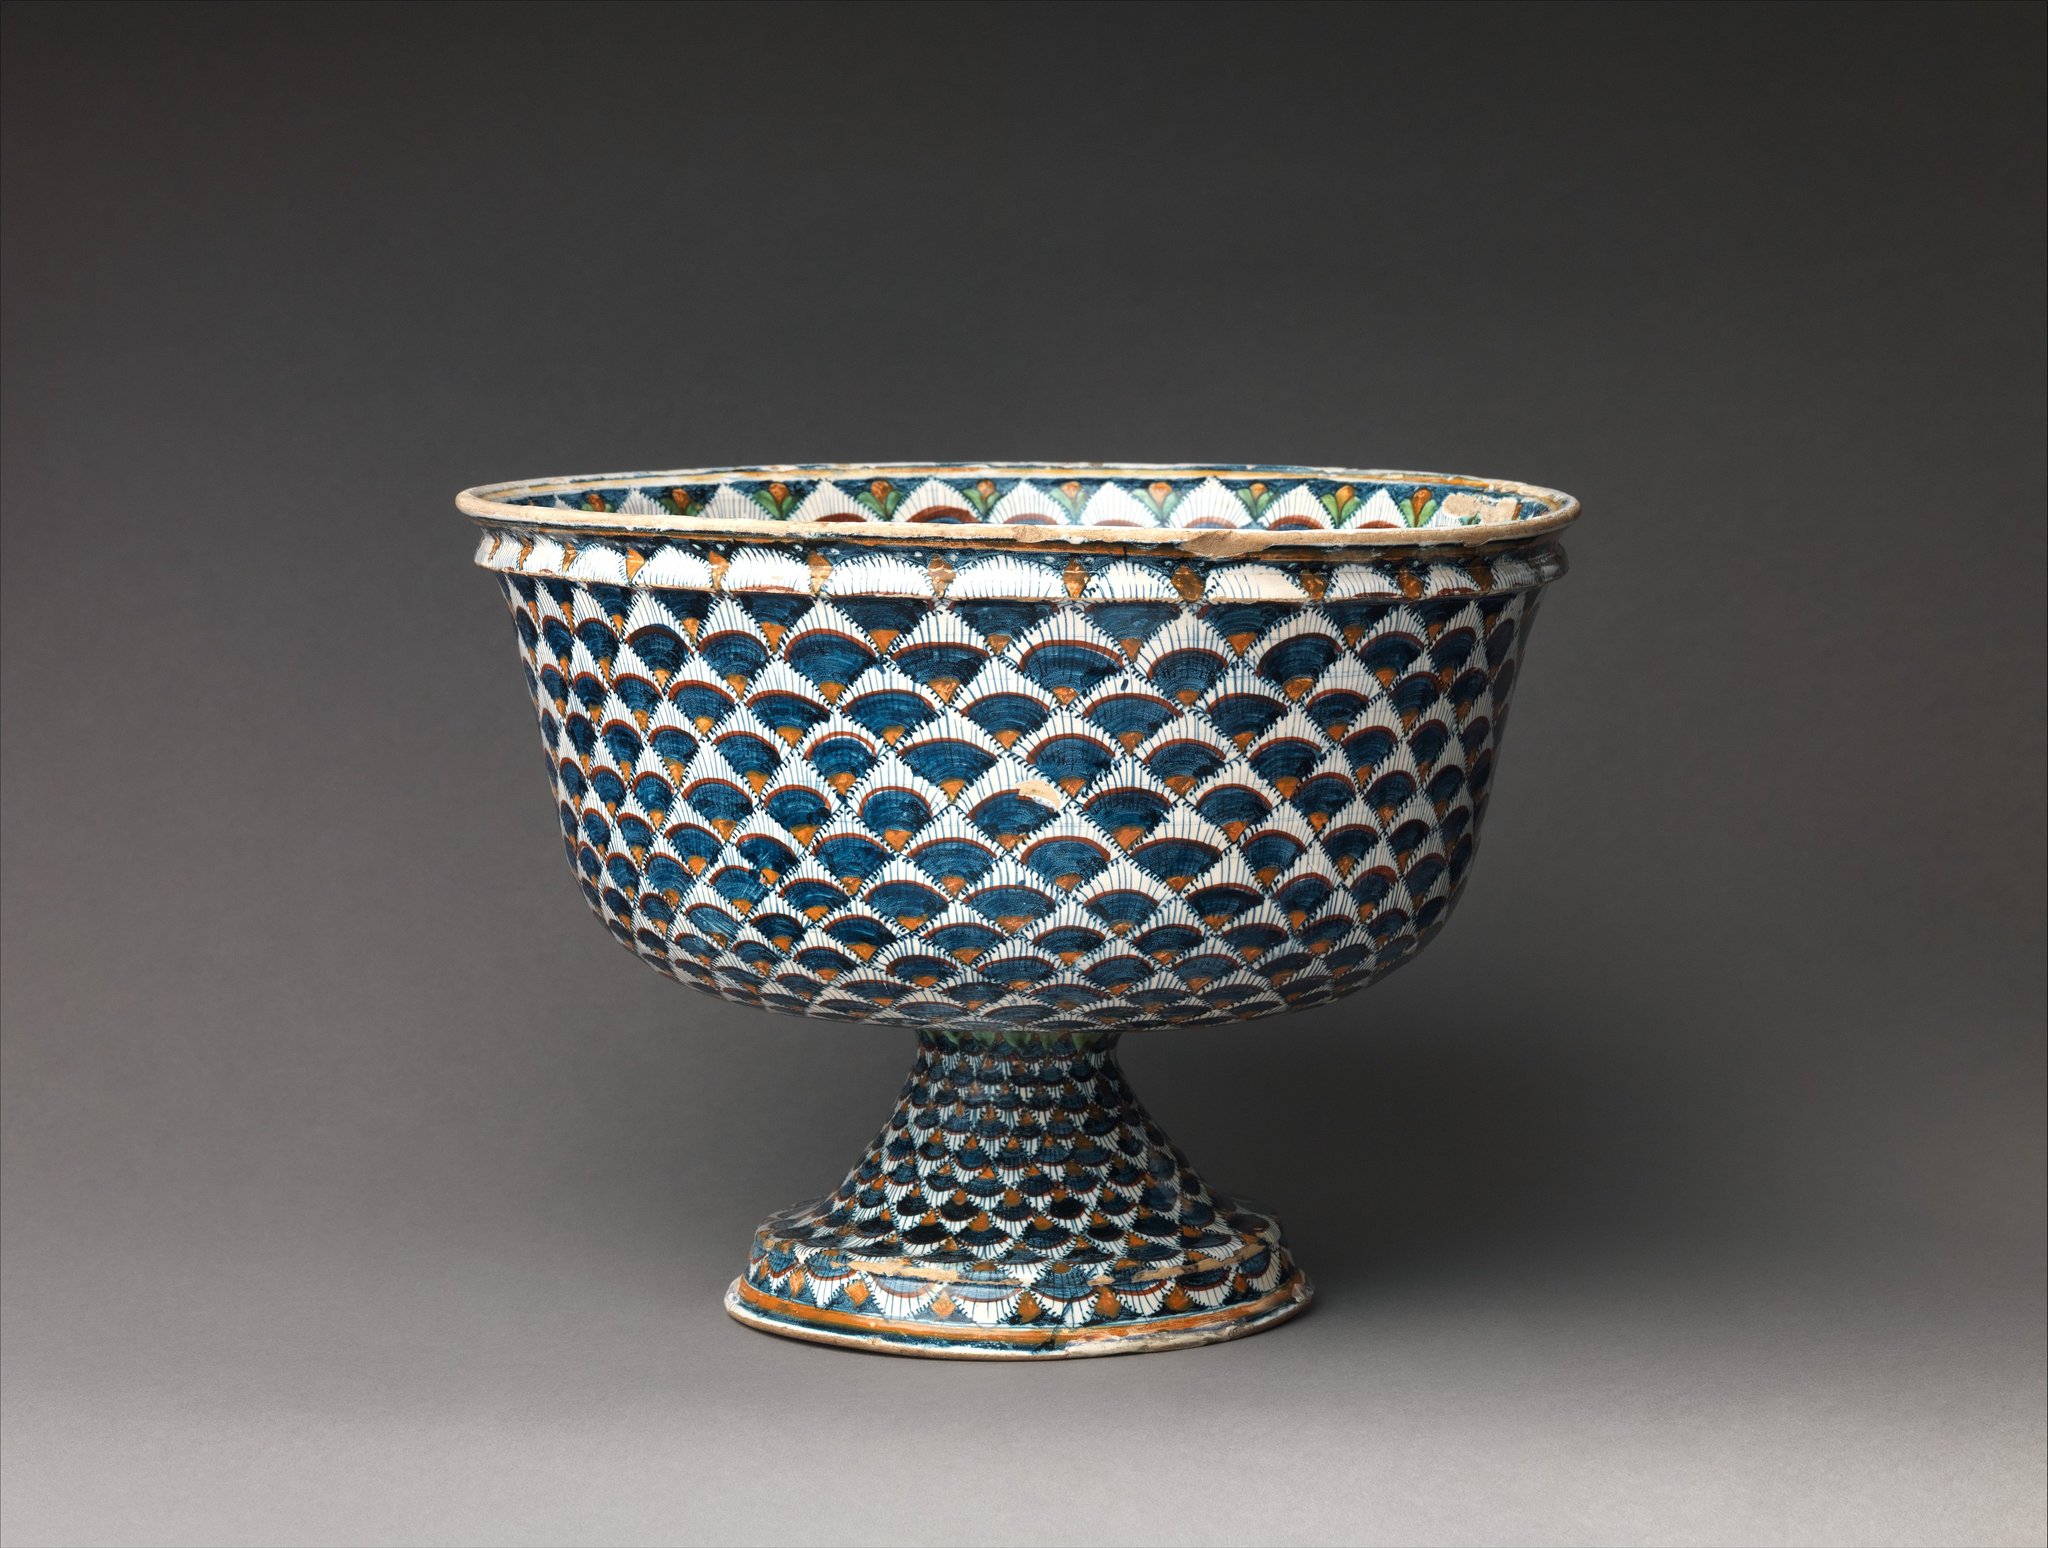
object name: bowl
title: Bowl on foot with arms of the Ridolfi di Borgo family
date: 1480-1500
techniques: maiolica, glazing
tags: coat of arms